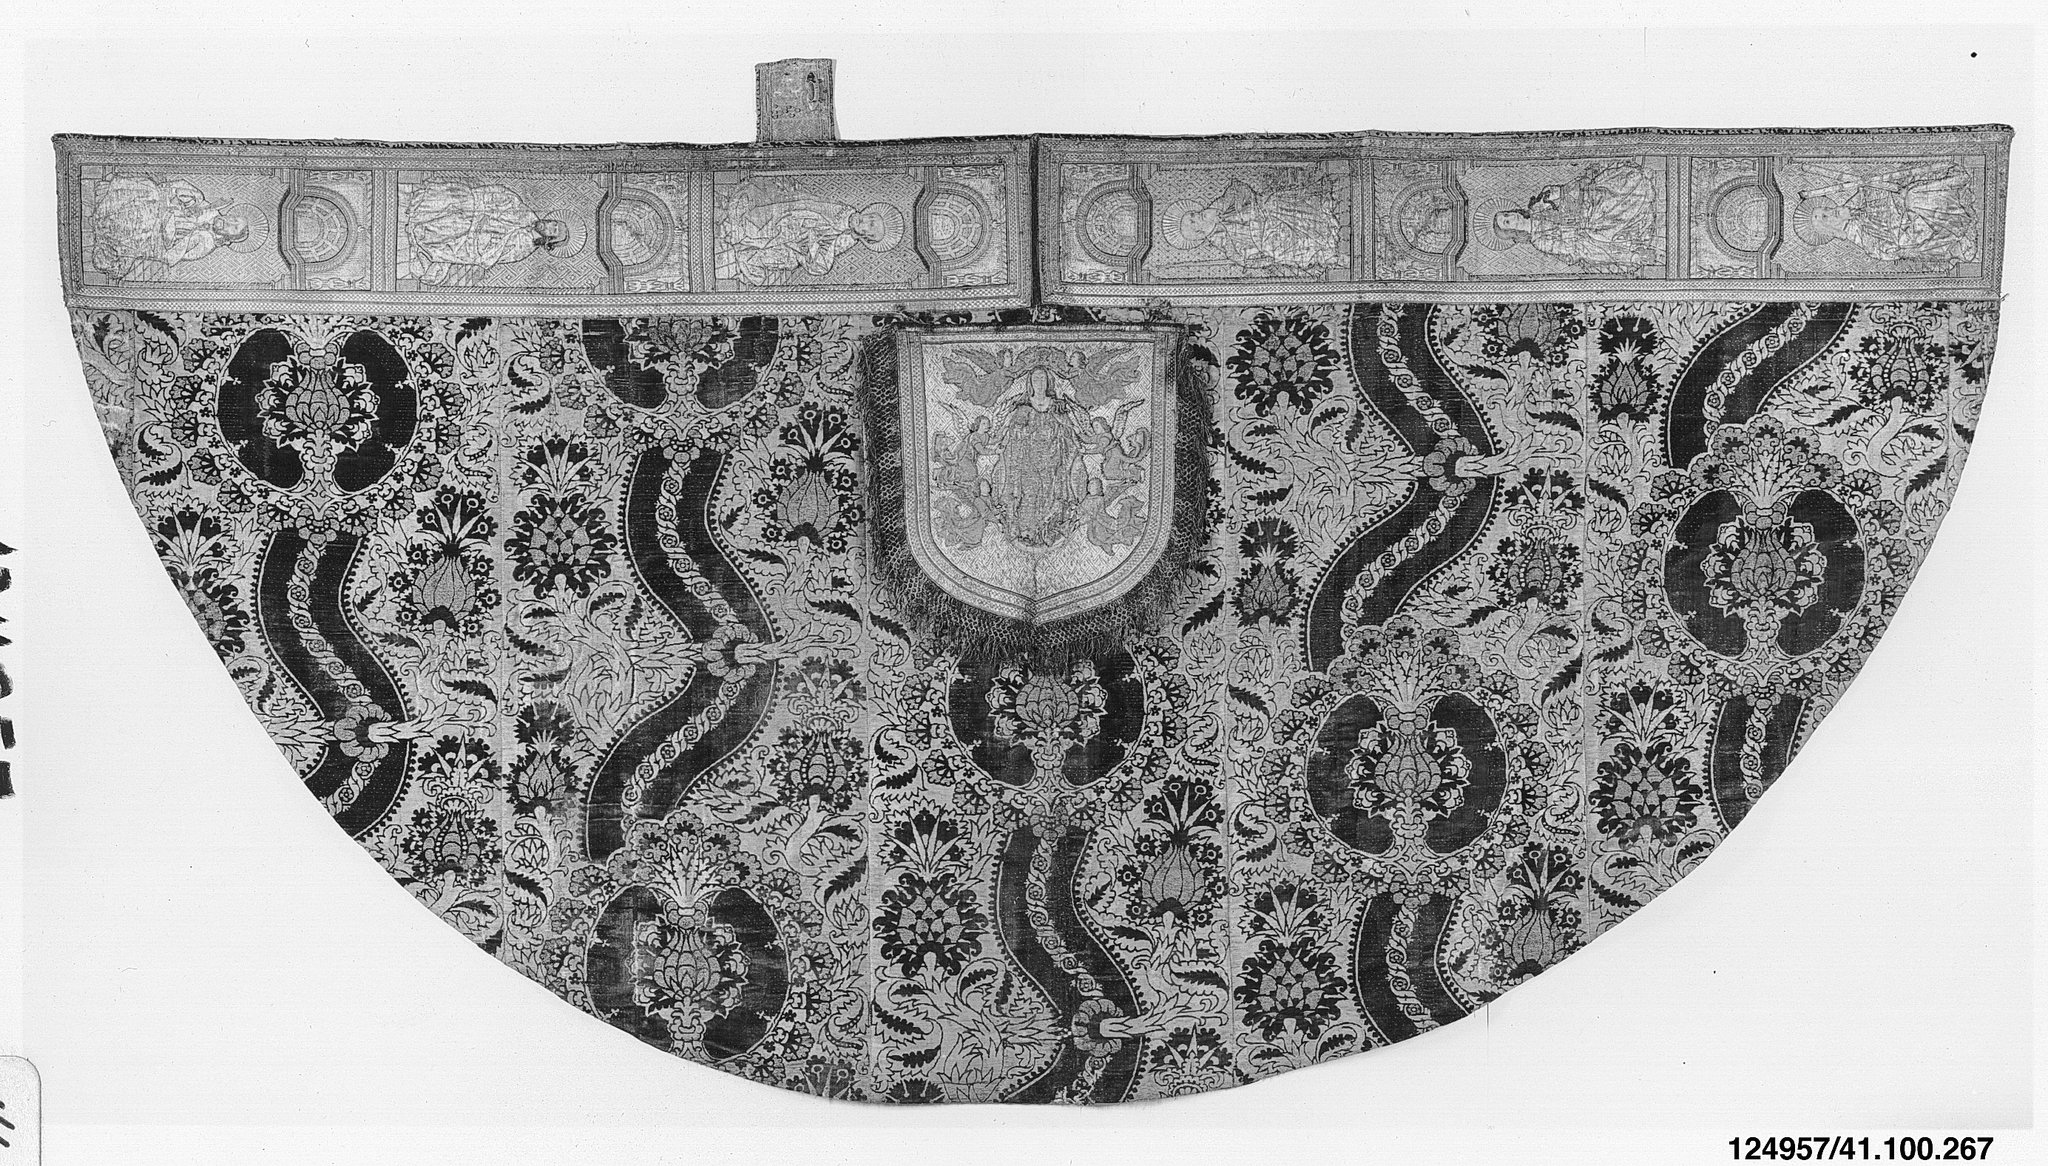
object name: cope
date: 1501-1533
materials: metal thread, silk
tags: angels,virgin mary,saints